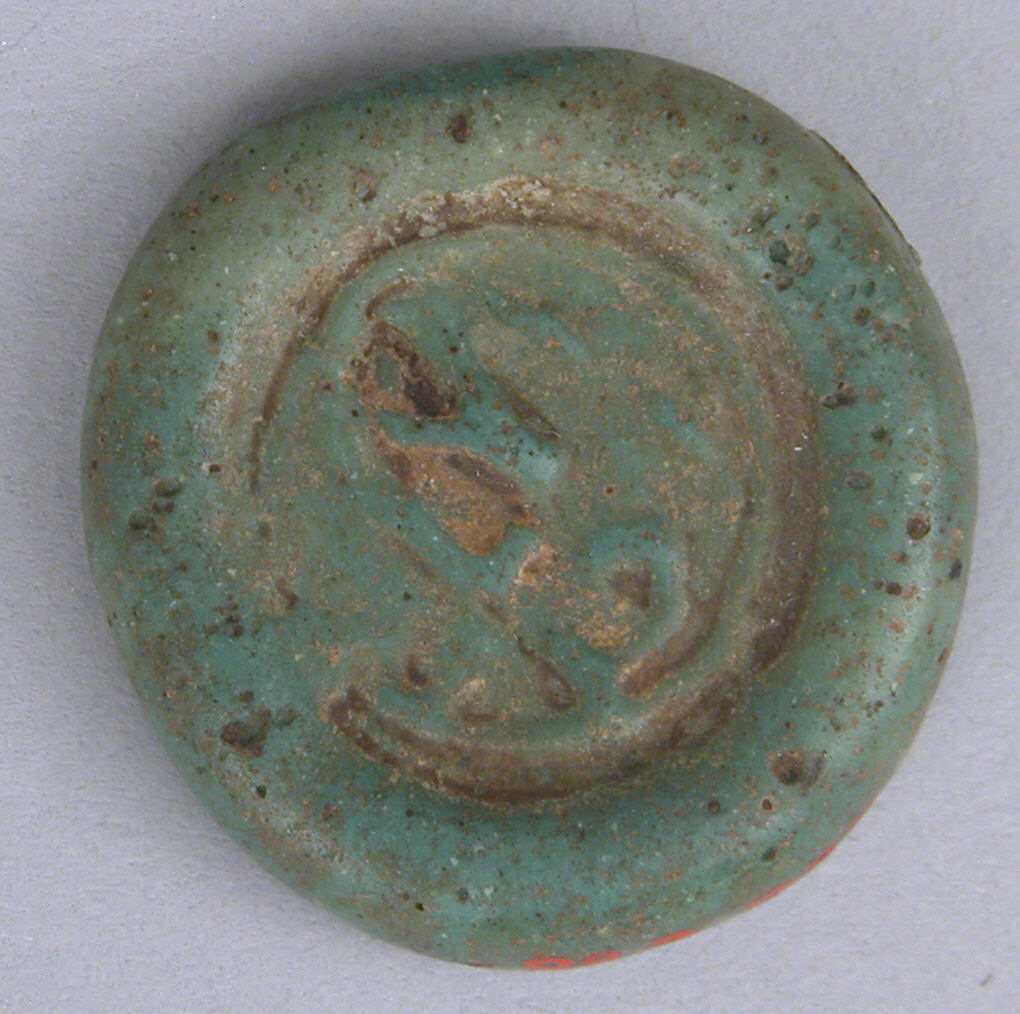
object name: coin weight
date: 1001-1100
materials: glass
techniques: stamping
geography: egypt